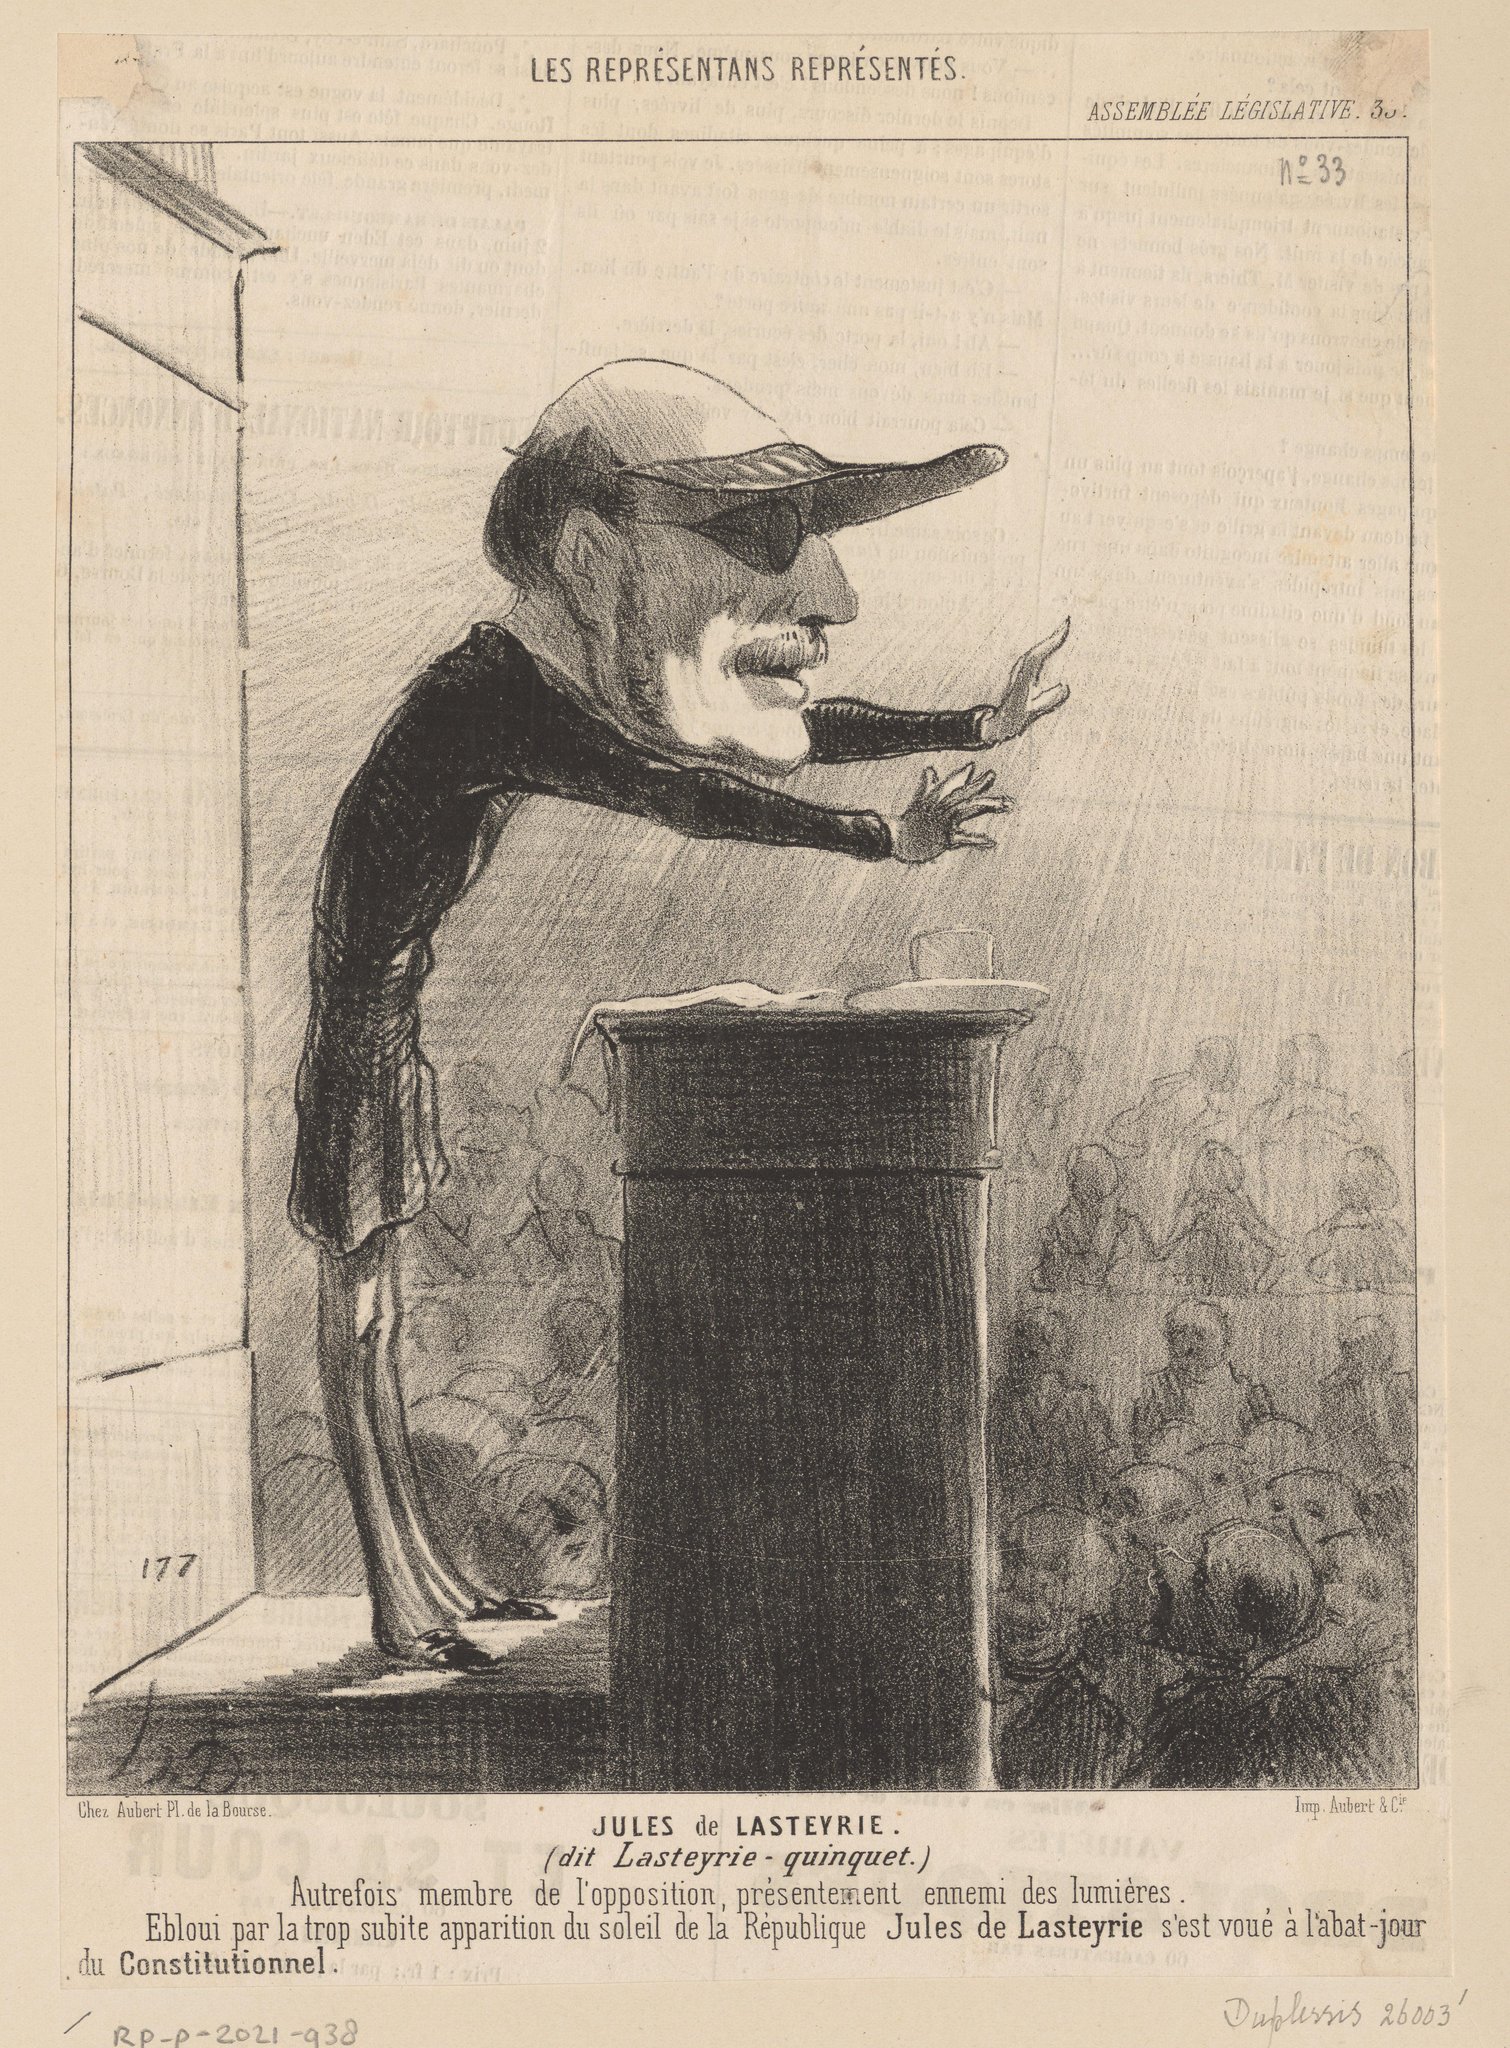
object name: print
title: Karikaturen van volksvertegenwoordigers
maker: honoré daumier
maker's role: draughtsman, painter, print maker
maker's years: 1808-1879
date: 1850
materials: paper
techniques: letterpress printing, lithograph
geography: france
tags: paris, politician, historical persons, politician, e.g. party leader, political caricatures and satires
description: Met onderschrift in het Frans. De Lasteyrie spreekt een groep mensen toe. Boven: Les Représentans représentés. Assemblée Législative. 33. Genummerd linksonder: 177.